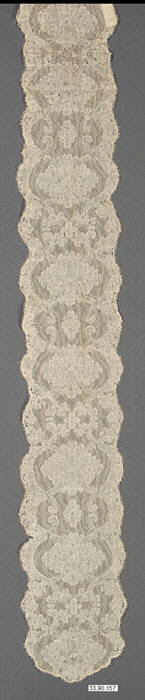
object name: lappet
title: Lappets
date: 1734-1766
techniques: lace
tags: flowers